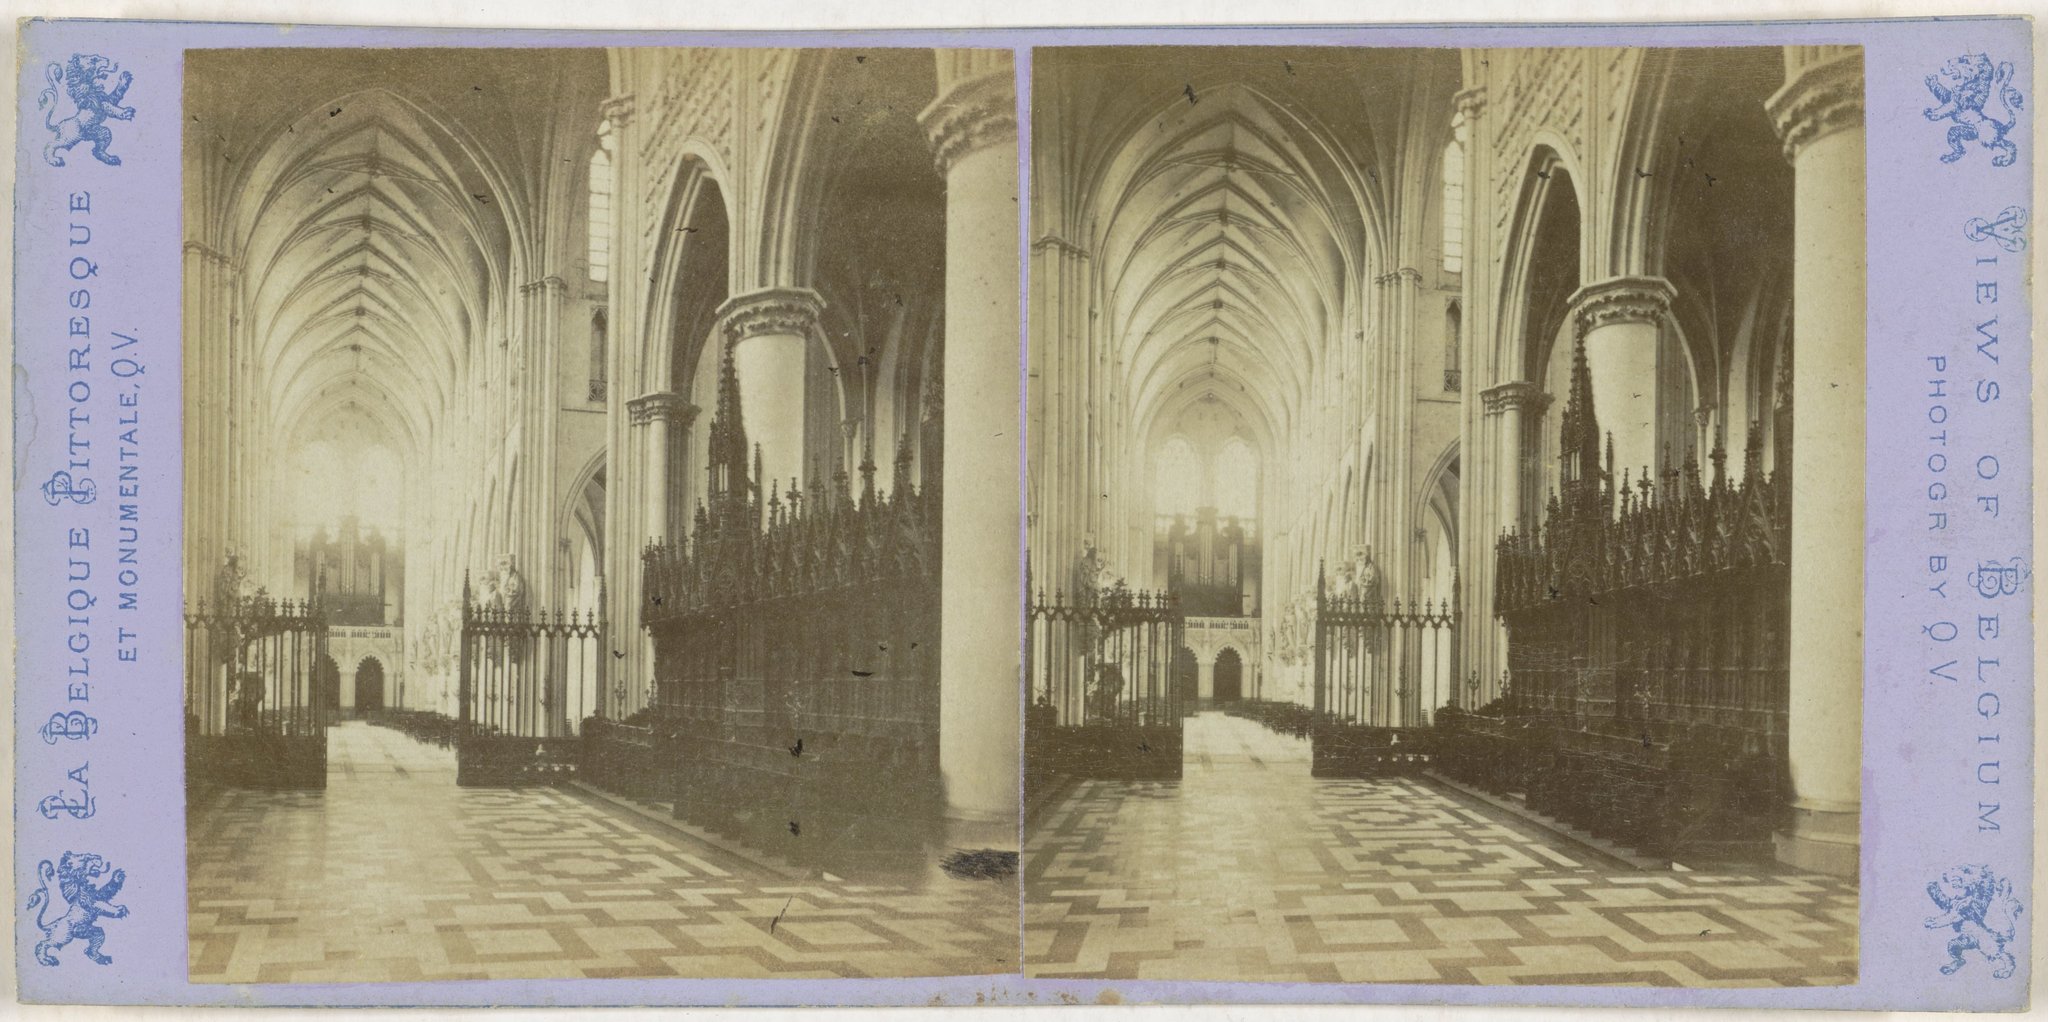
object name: stereograph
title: La Belgique pittoresque et monumentale / Views of Belgium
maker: jules hippolyte quéval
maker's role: publisher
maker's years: 1824-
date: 1866-1870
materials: cardboard, paper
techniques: albumen print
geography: mechelen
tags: parts of church interior: ambulatory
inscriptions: number: ‘No 1636’